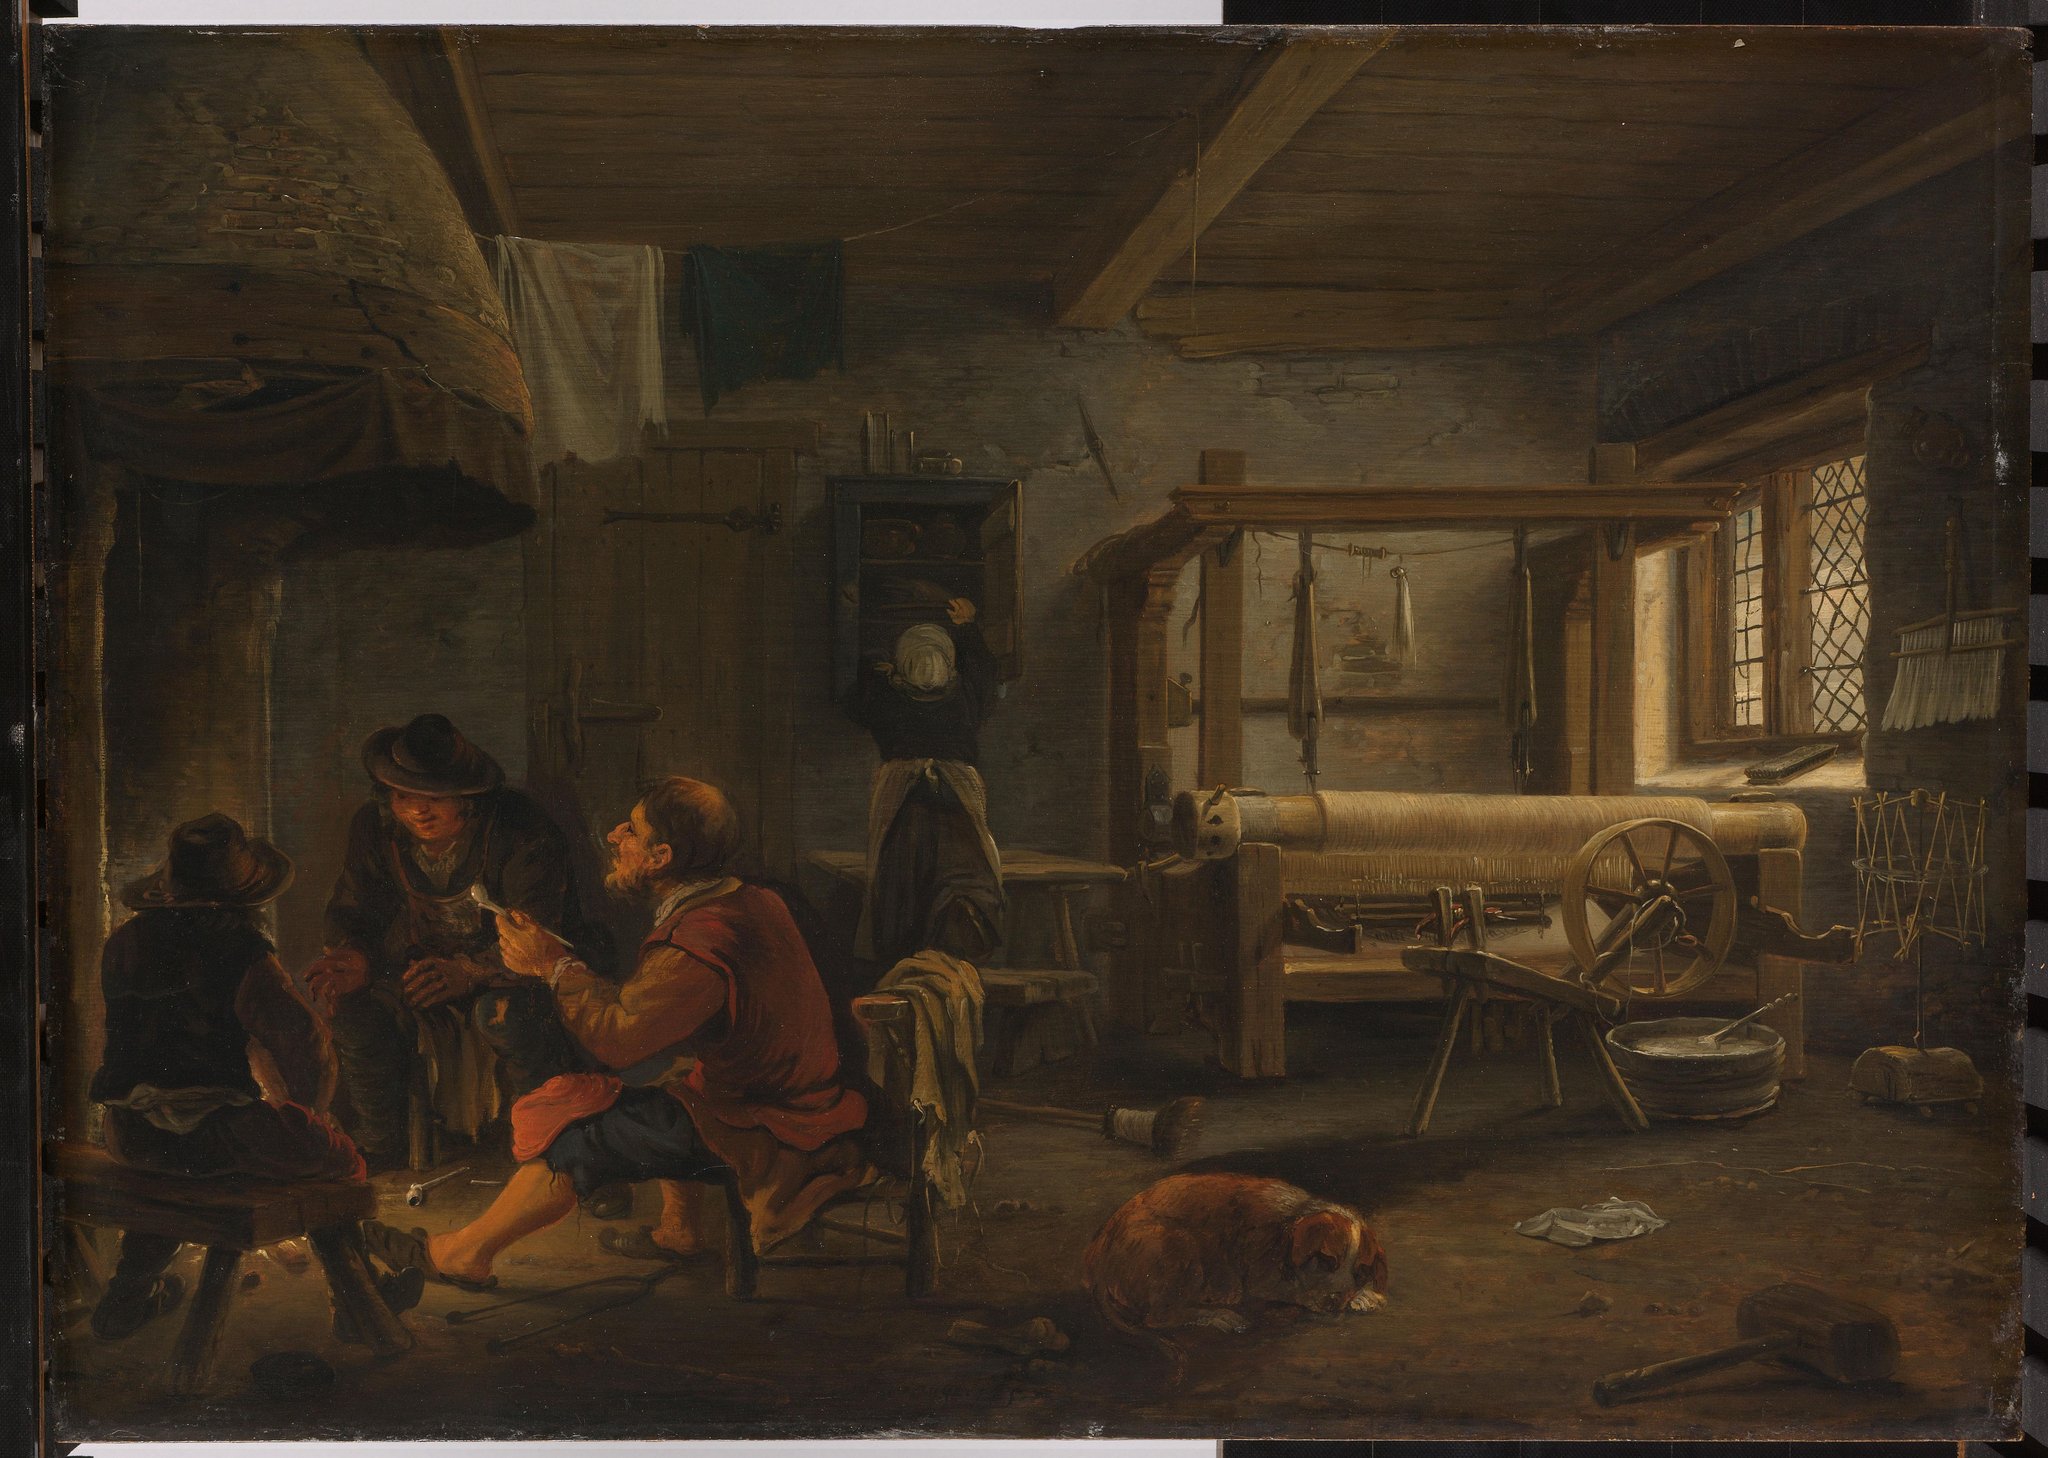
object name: painting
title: A Weaver's Workshop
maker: johannes dircksz. van oudenrogge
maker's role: painter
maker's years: 1622-1653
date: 1652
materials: oil, panel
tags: weaving-loom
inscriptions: signature and date: ‘J. Oudenrogge 1652’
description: Weverswerkplaats. Interieur van een weverij, links rusten drie mannen bij een haard, rechts bij het raam staat een weefgetouw, een spoelwiel, een haspel, een lijmtobbe en ander gereedschap. Op de voorgrond slaapt een hond, bij de achtermuur opent een vrouw een wandkast.